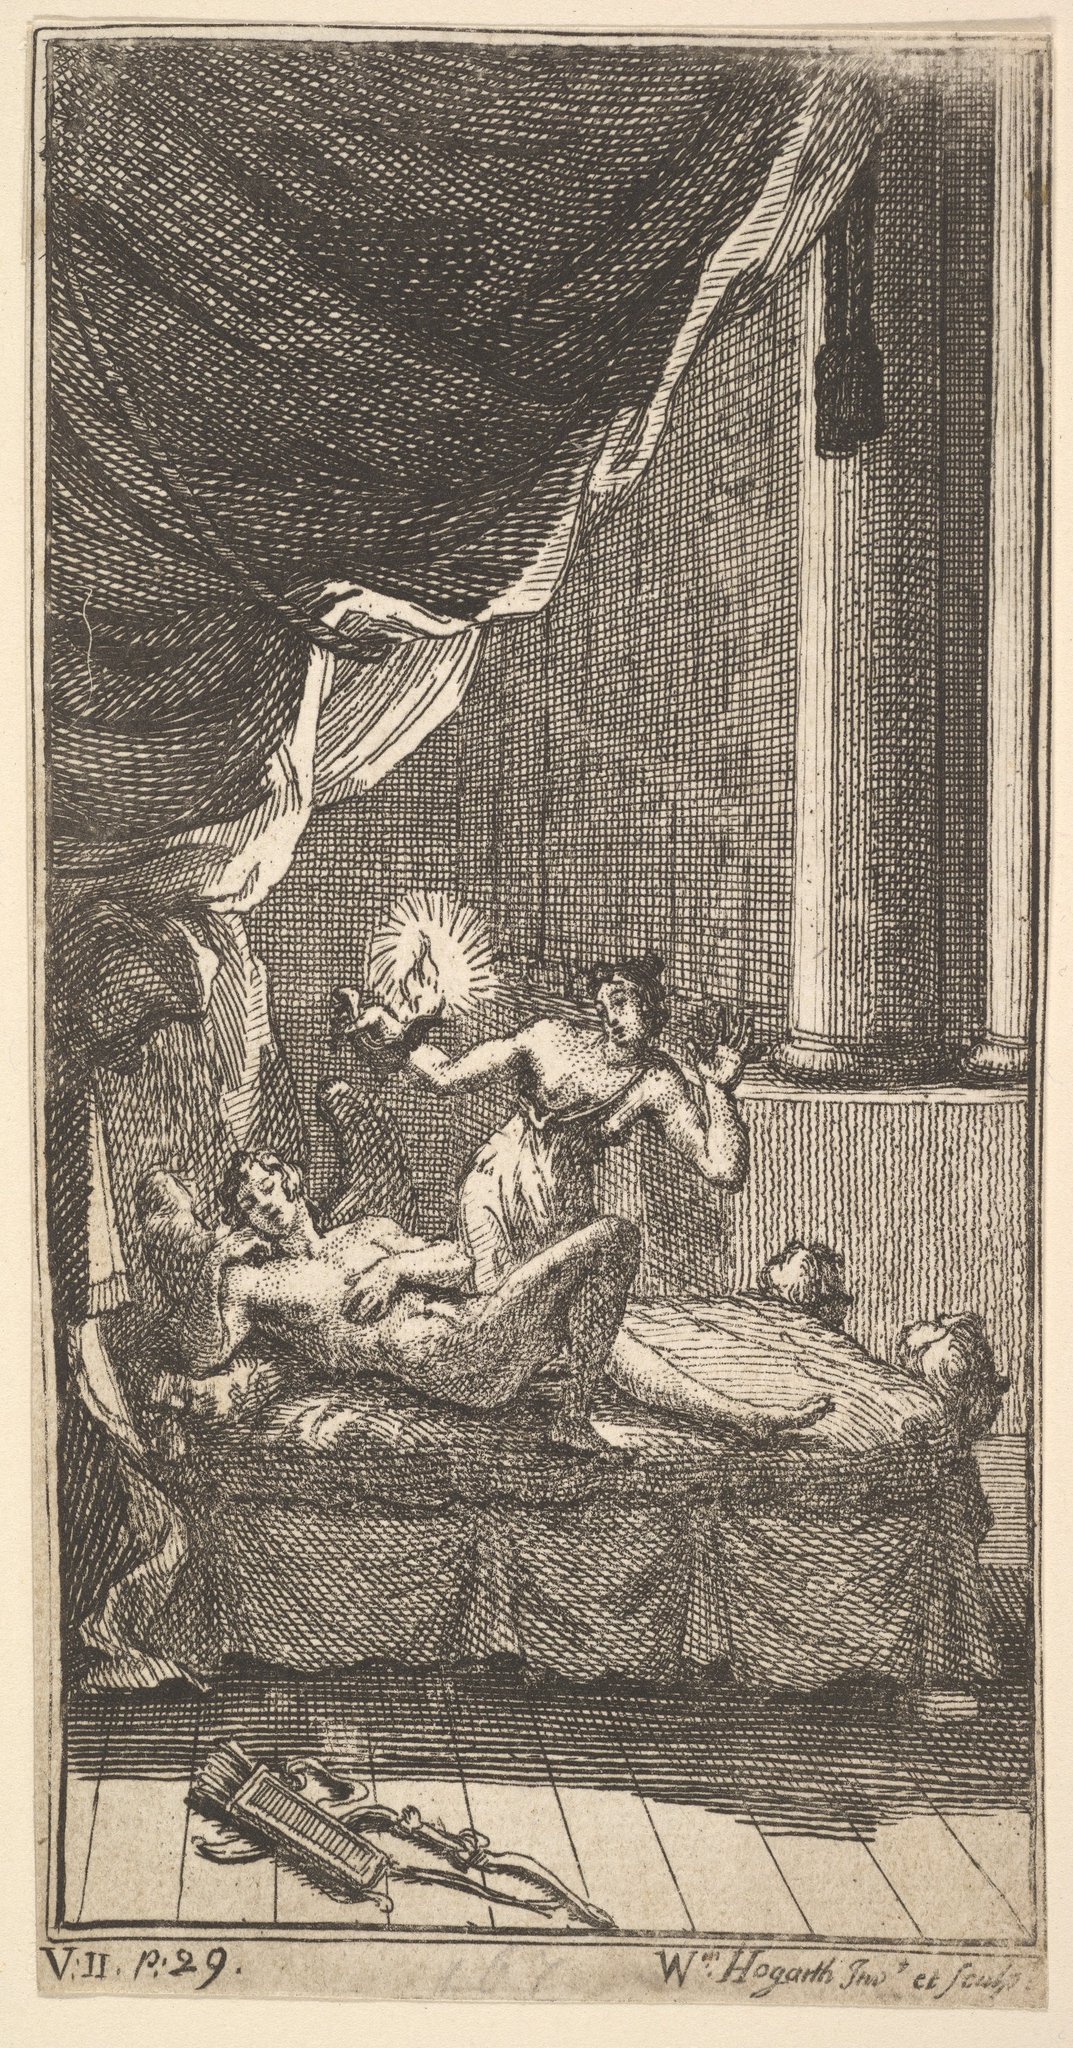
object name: print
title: The New Metamorphosis, Plate 6: The Story of Cupid and Psyche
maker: william hogarth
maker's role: artist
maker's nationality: british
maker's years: 1697-1764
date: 1724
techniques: engraving, etching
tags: cupid,psyche